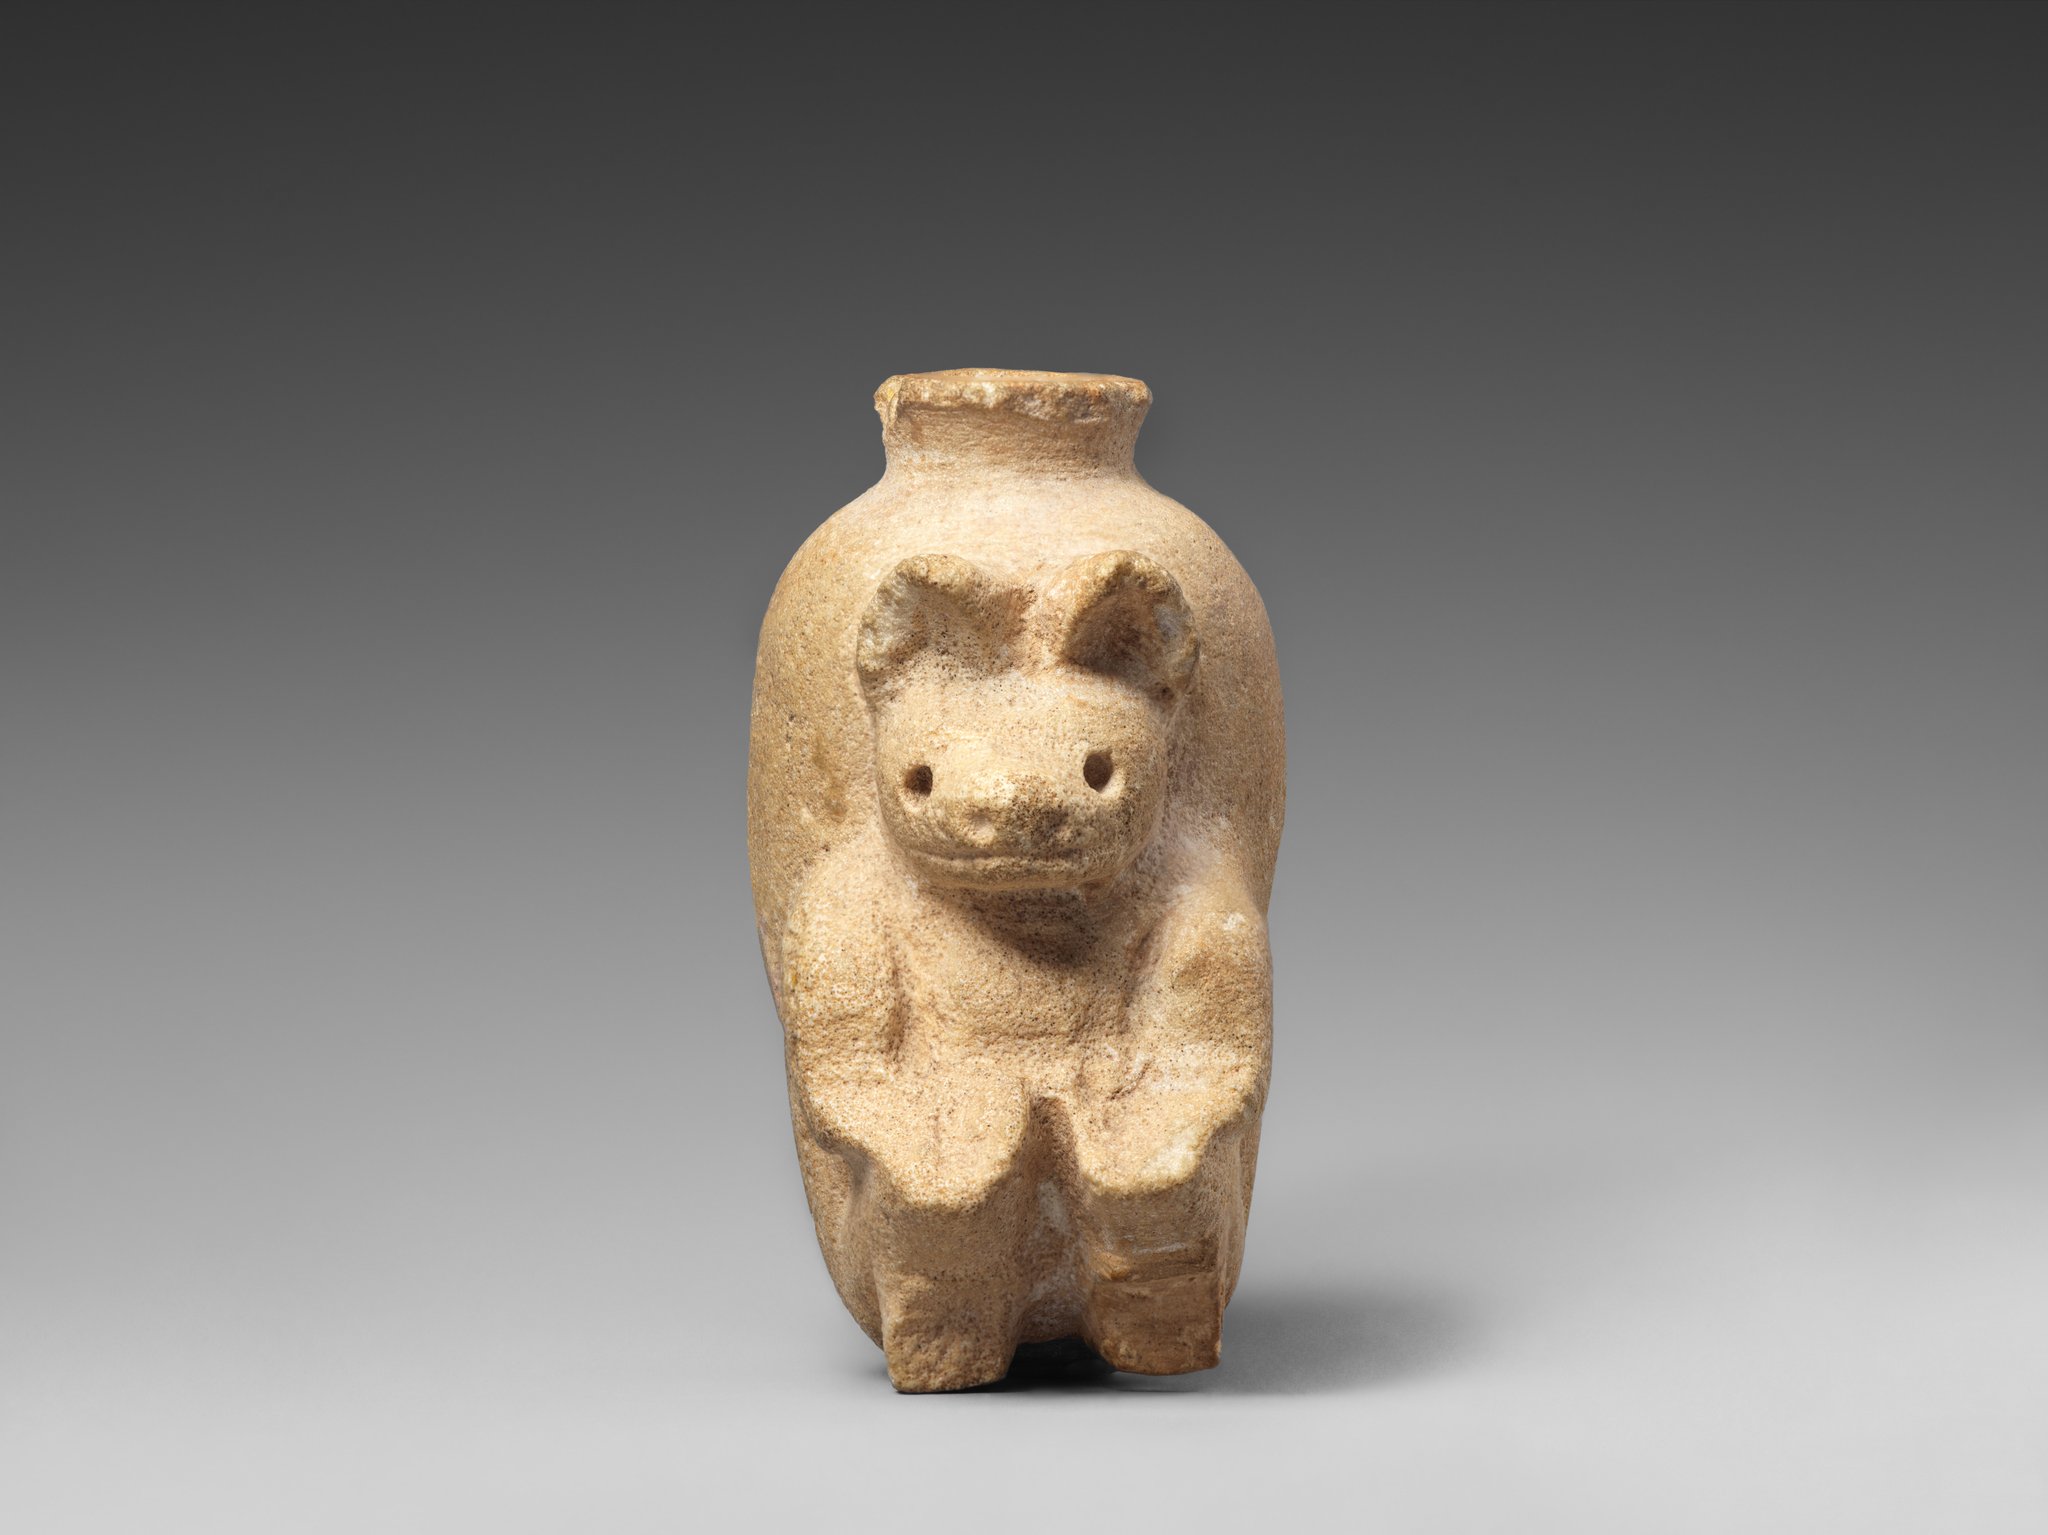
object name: jar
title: Jar with bear figurine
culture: proto-elamite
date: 3100-2900 BCE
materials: alabaster, gypsum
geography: iran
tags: bears